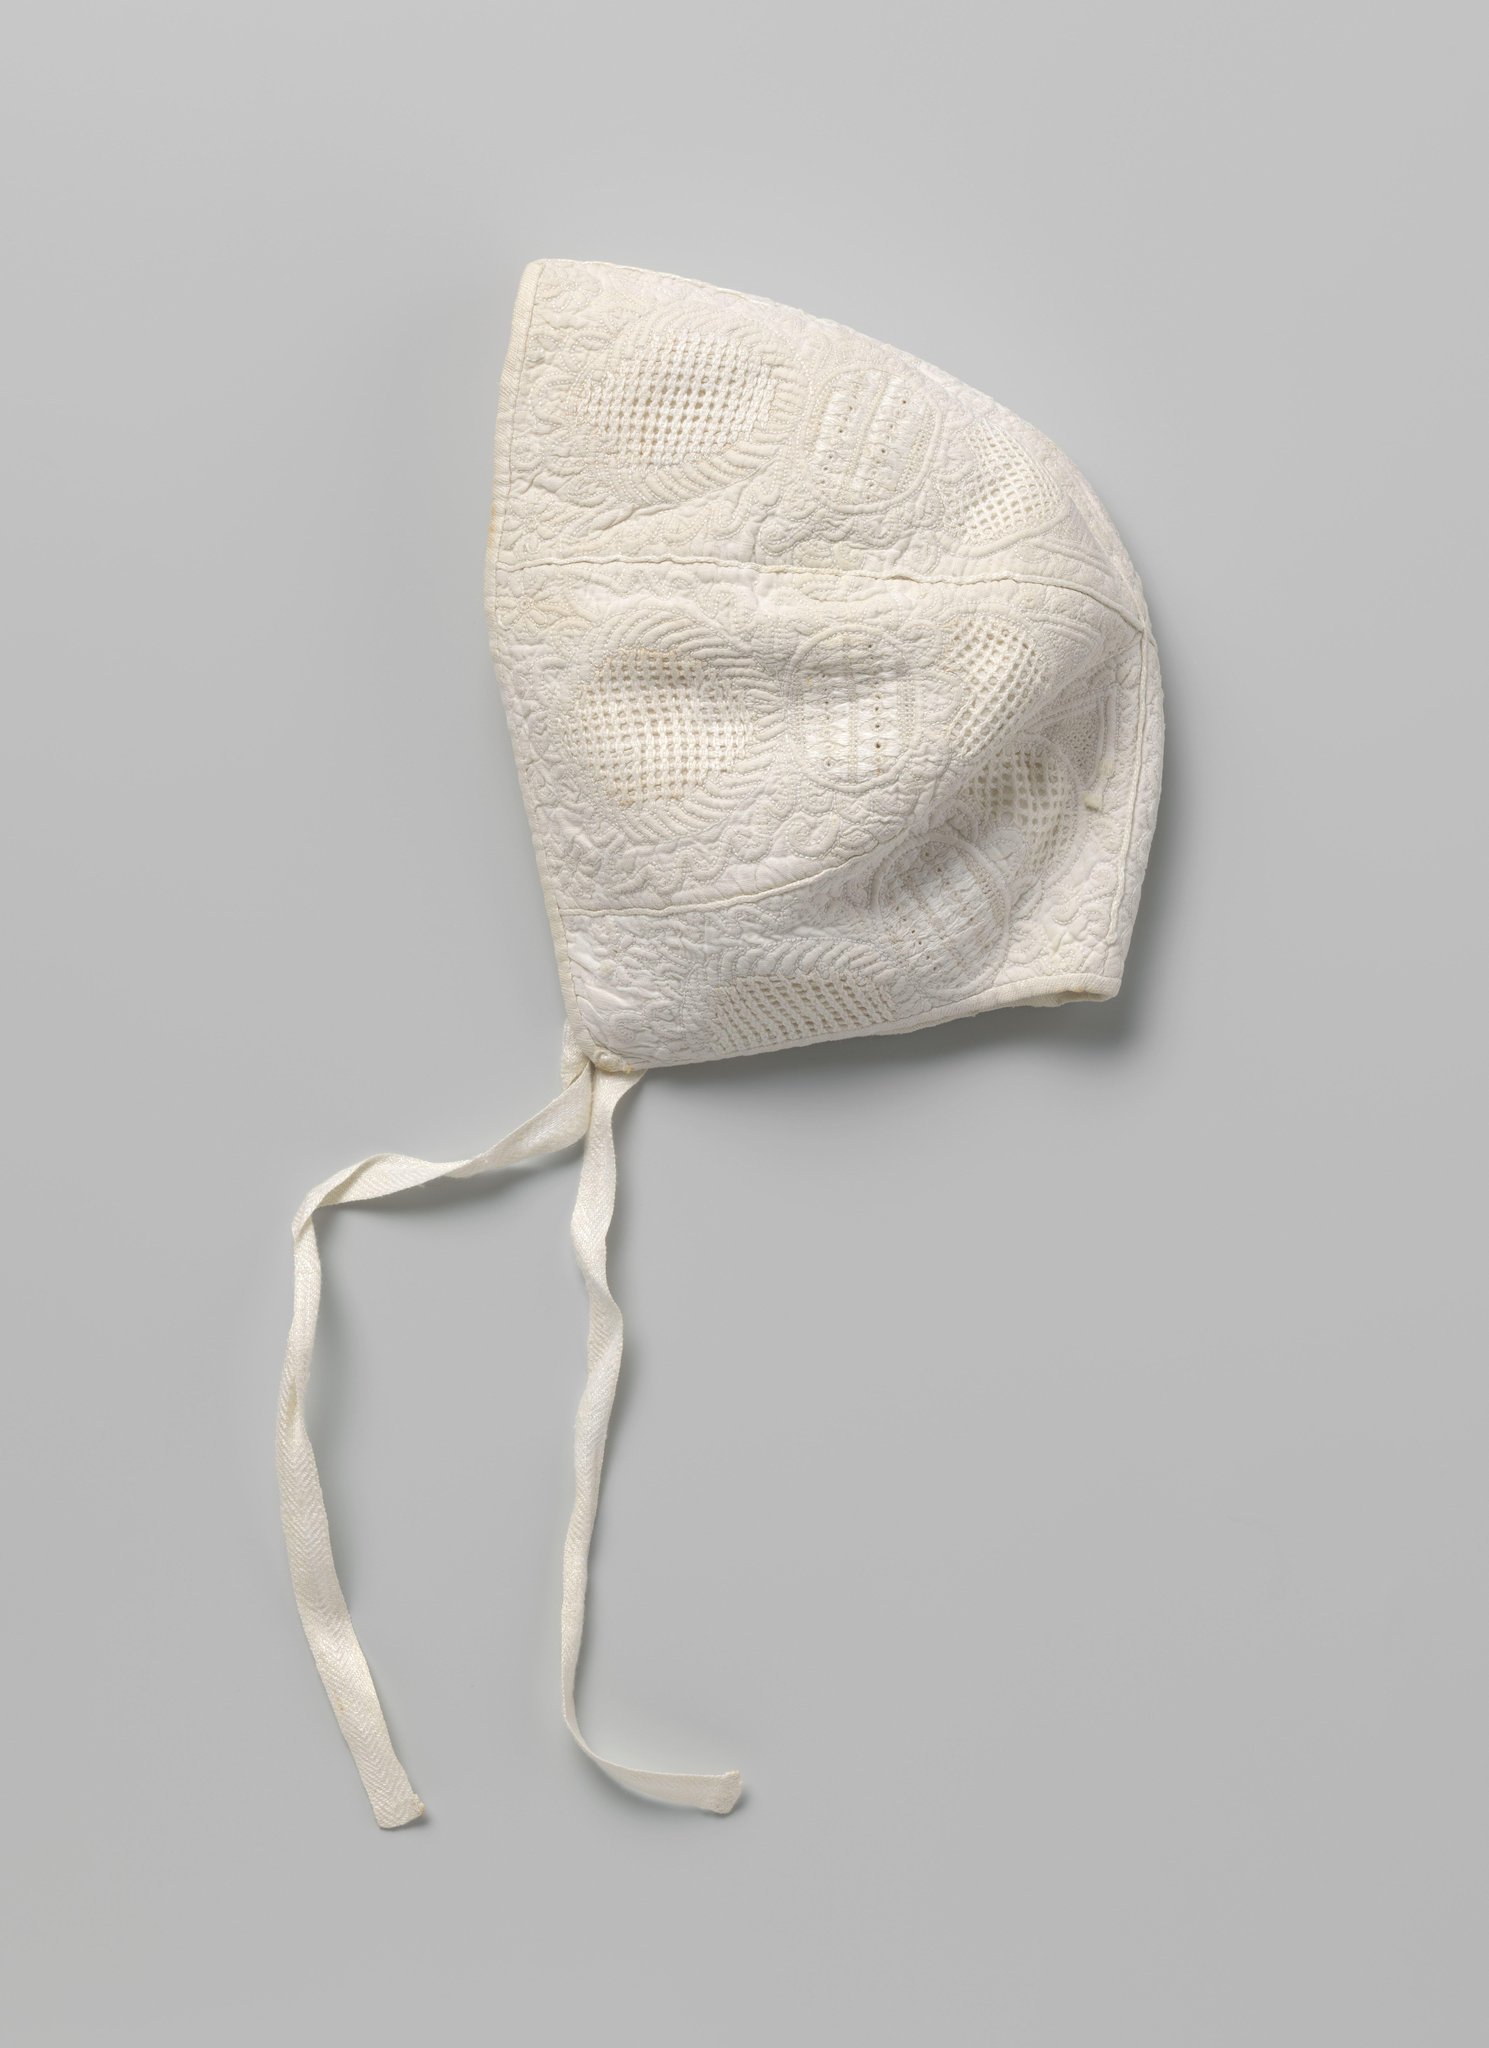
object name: cap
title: Katoenen muts met Zaans stikwerk, verdeeld in zes vakken, waarin cirkel- en ellipsvormige bloemmotieven; op de kruin een rozet met driehoeken en kleine bladeren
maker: Anonymous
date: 1700-1750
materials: cotton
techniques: embroidered, quilting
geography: netherlands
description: Muts met Zaans stikwerk, verdeeld in zes vakken waarin cirkel- en ellipsvormige bloemmotieven. Op de kruin heeft het patroon een rozet met driehoeken en kleine bladeren.